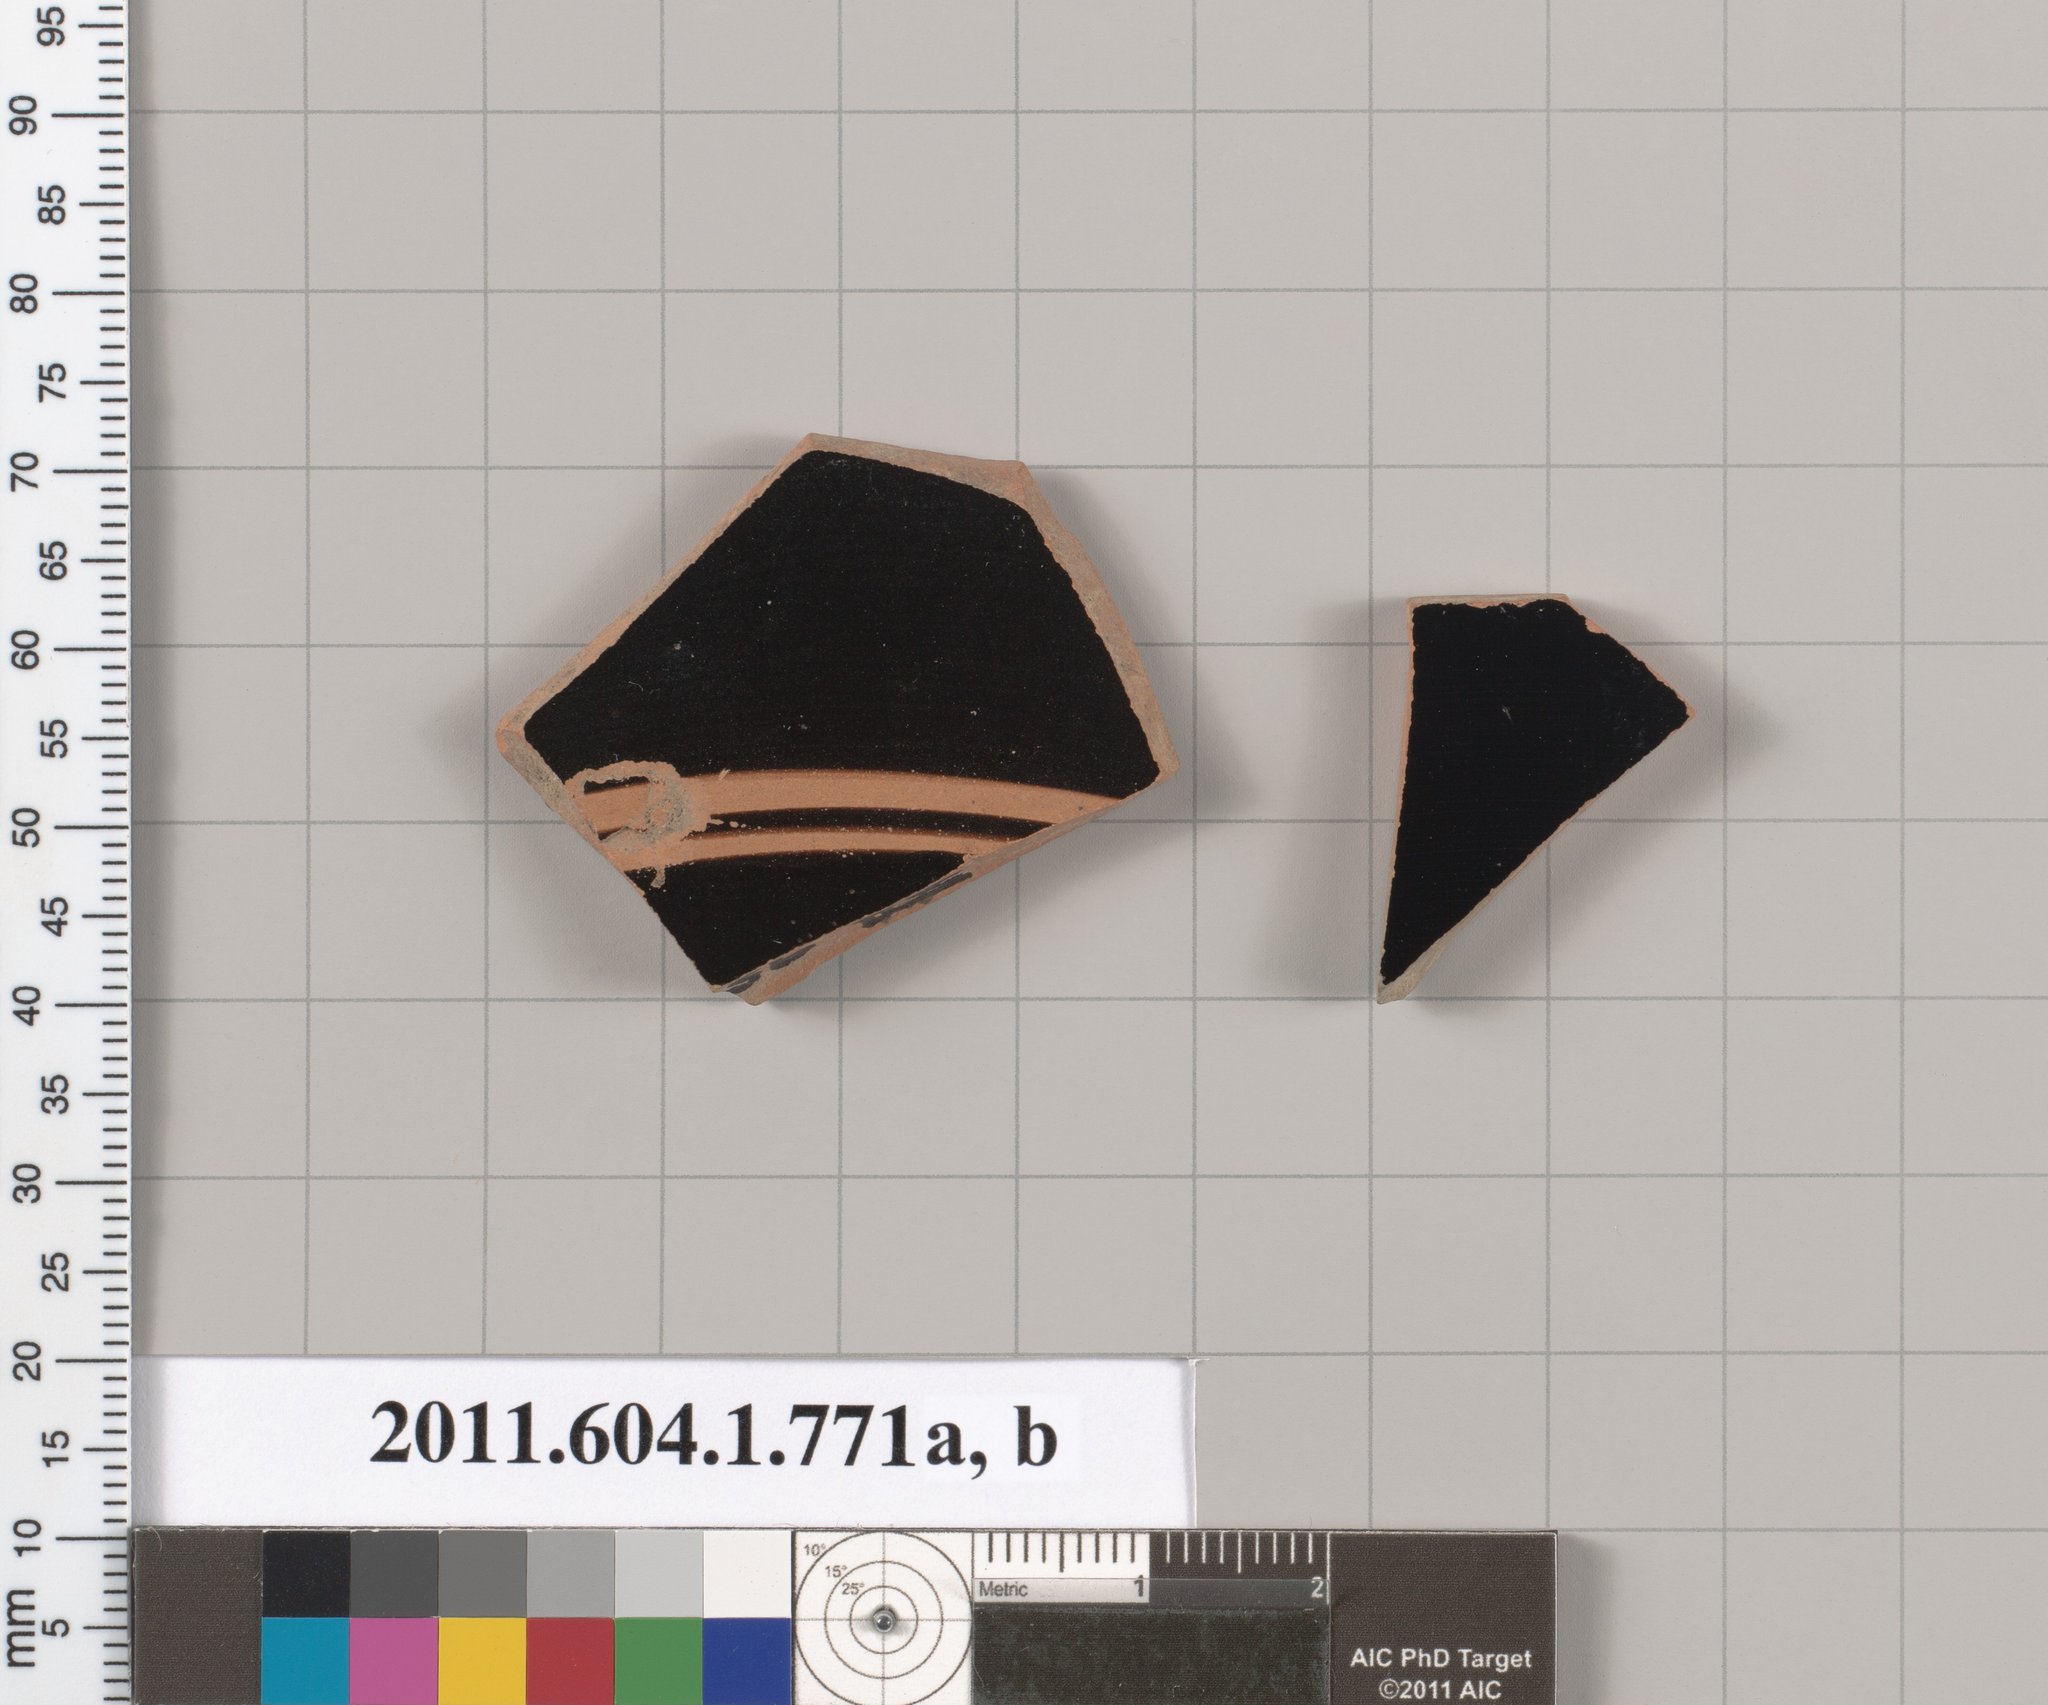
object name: kylix fragment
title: Terracotta fragments of kylikes (drinking cups)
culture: greek, attic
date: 500-401 BCE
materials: terracotta